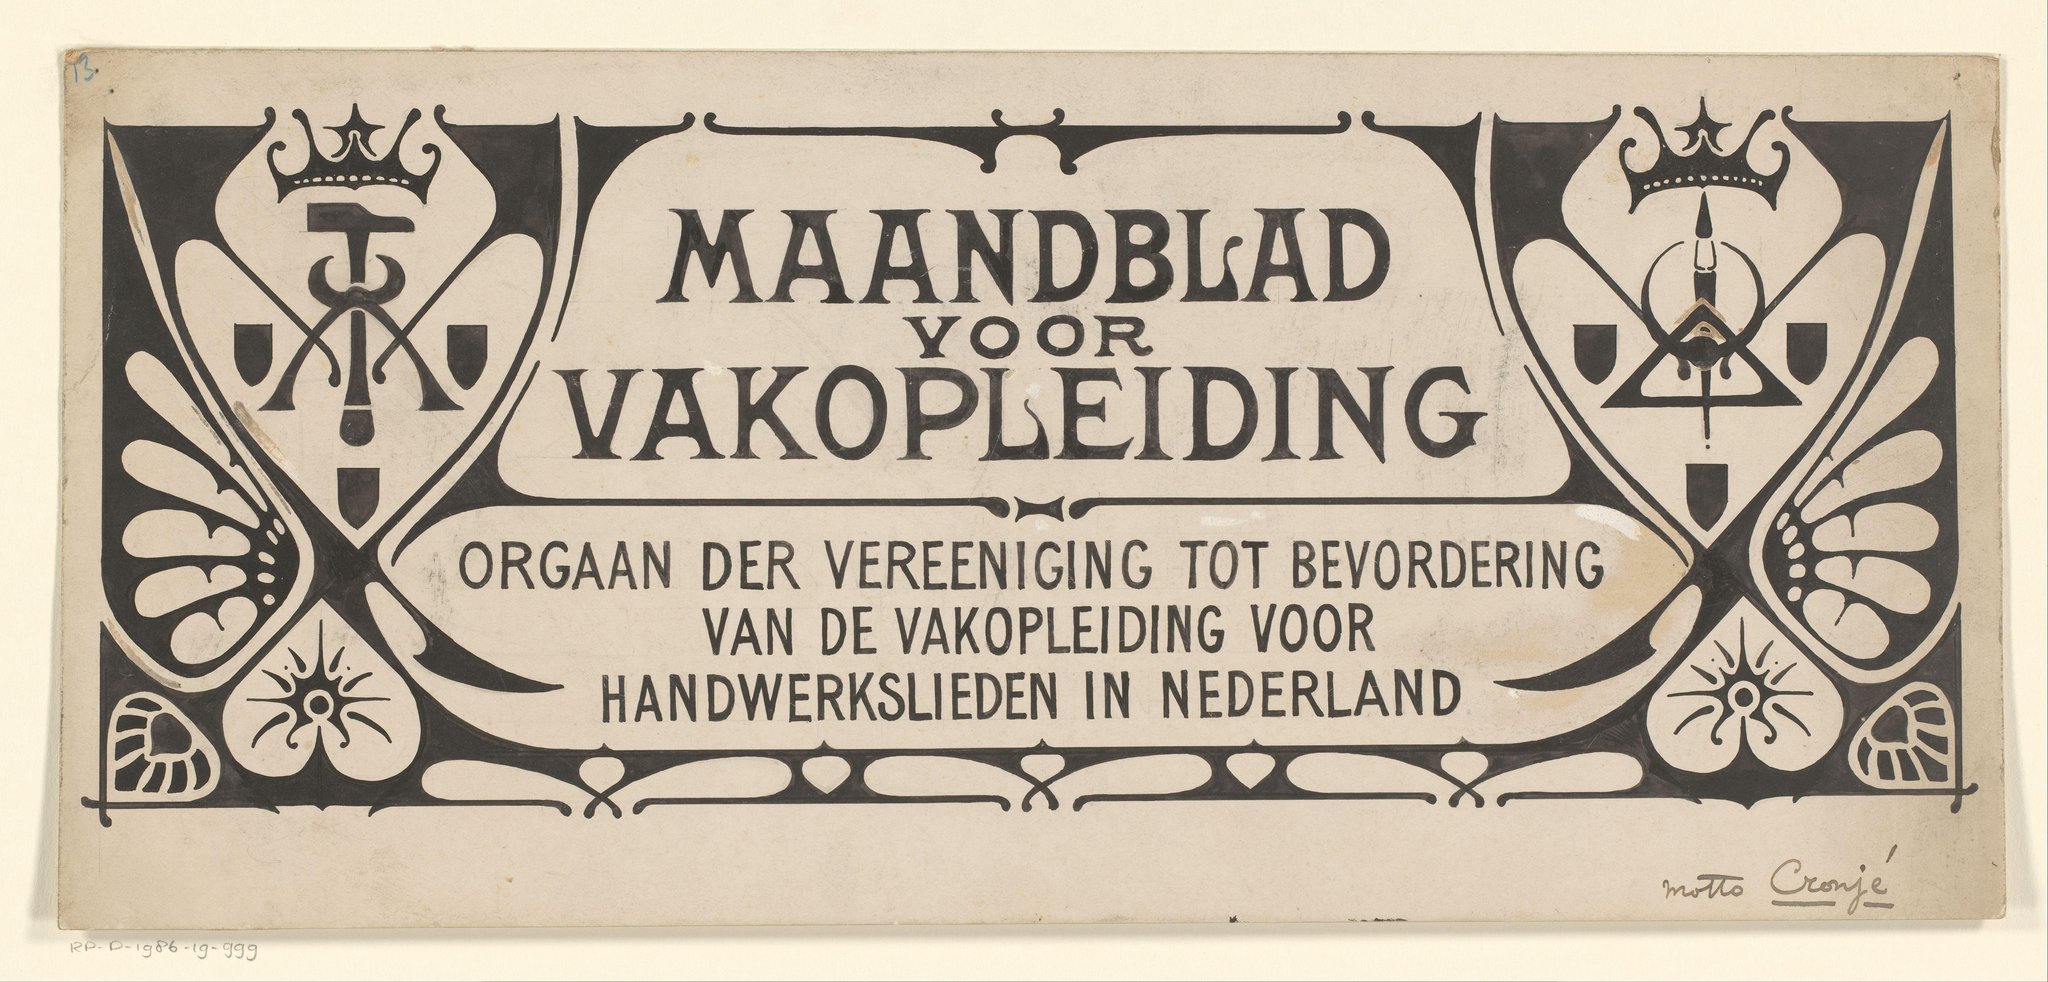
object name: drawing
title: Ontwerp voor een titelhoofd van het Maandblad voor Vakopleiding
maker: reinier willem petrus de vries (1874-1953)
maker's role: draughtsman, print maker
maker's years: 1874-1953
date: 1884-1952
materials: cardboard, paint, ink, pencil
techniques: brush, pen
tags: tools, implements of craftsman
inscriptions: annotation: ‘motto Cronjé’, collector's mark: ‘R:MVS.’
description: Links en rechts van de tekst een ornament met daarin verschillende attributen van handwerkslieden en daarboven een kroon.